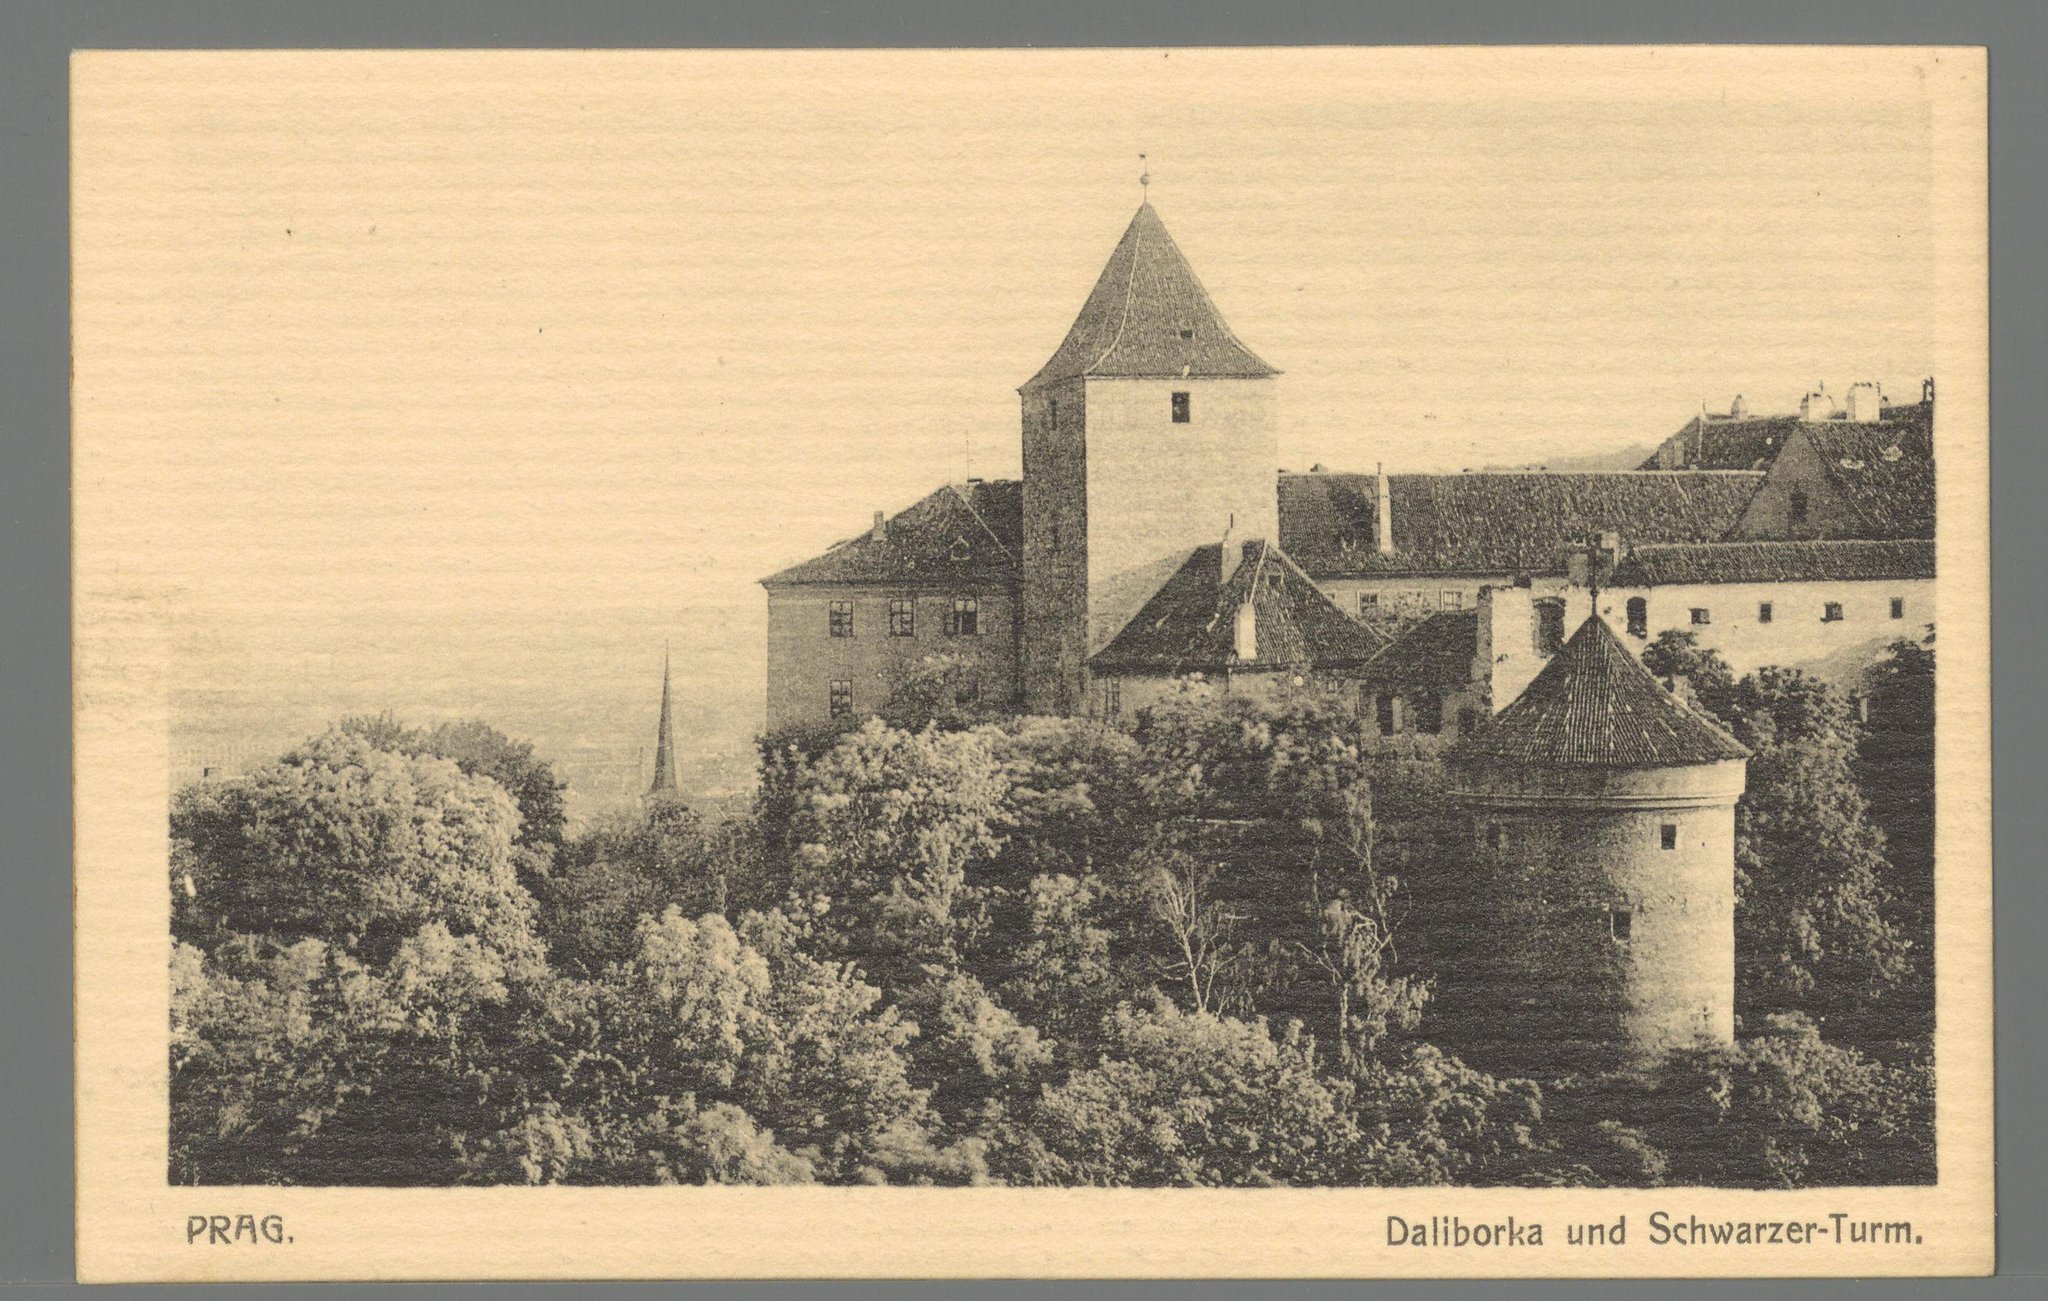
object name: ansichtkaart, prentbriefkaart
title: Prag. Daliborka und Schwarzer-Turm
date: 1911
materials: cardboard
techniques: photograph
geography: prague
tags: castle, towers ~ fortified city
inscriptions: date